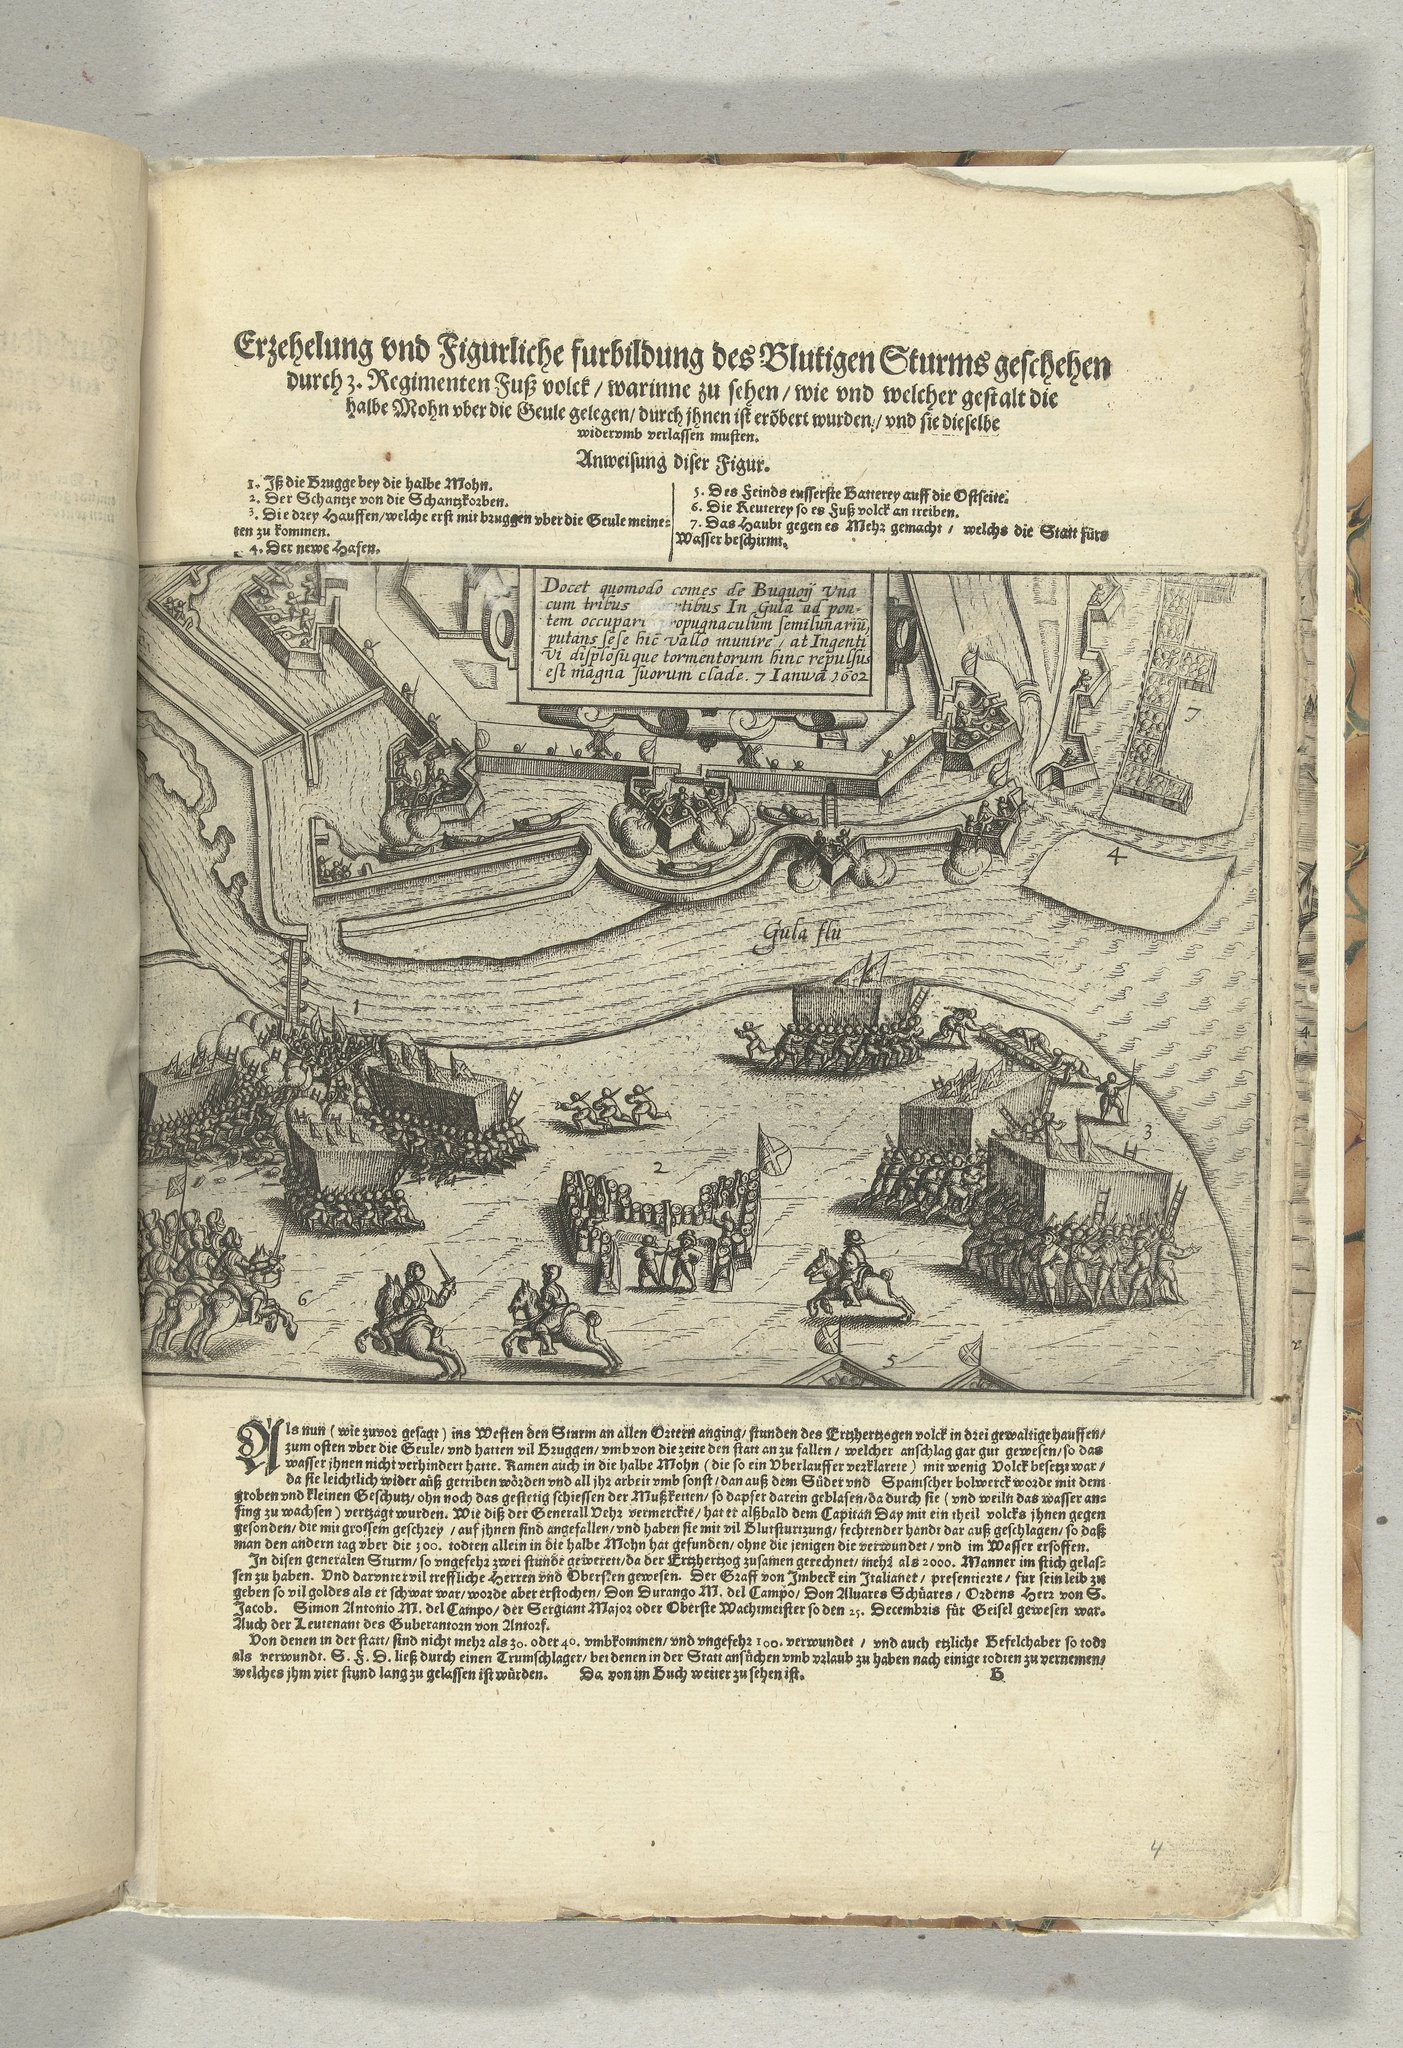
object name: print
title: Beleg van Oostende: bestorming door Bucquoy op 7 januari 1602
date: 1602-1604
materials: paper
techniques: etching, letterpress printing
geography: low countries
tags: siege, position war, battle (+ land forces)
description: Bestorming van de verdedigingswerken van Oostende door de Spaanse troepen onder de graaf van Bucquoy op 7 januari 1602. Linksonder gevechten bij de lunet aan de overzijde van de rivier de Geule, middenboven een cartouche met opschrift in het Latijn. Boven de prent de titel met verklaring van de cijfers, onderaan een beschrijving van de gebeurtenissen, in het Duits. Onderdeel van de illustraties bij een journaal van het beleg van Oostende 1601-1604.